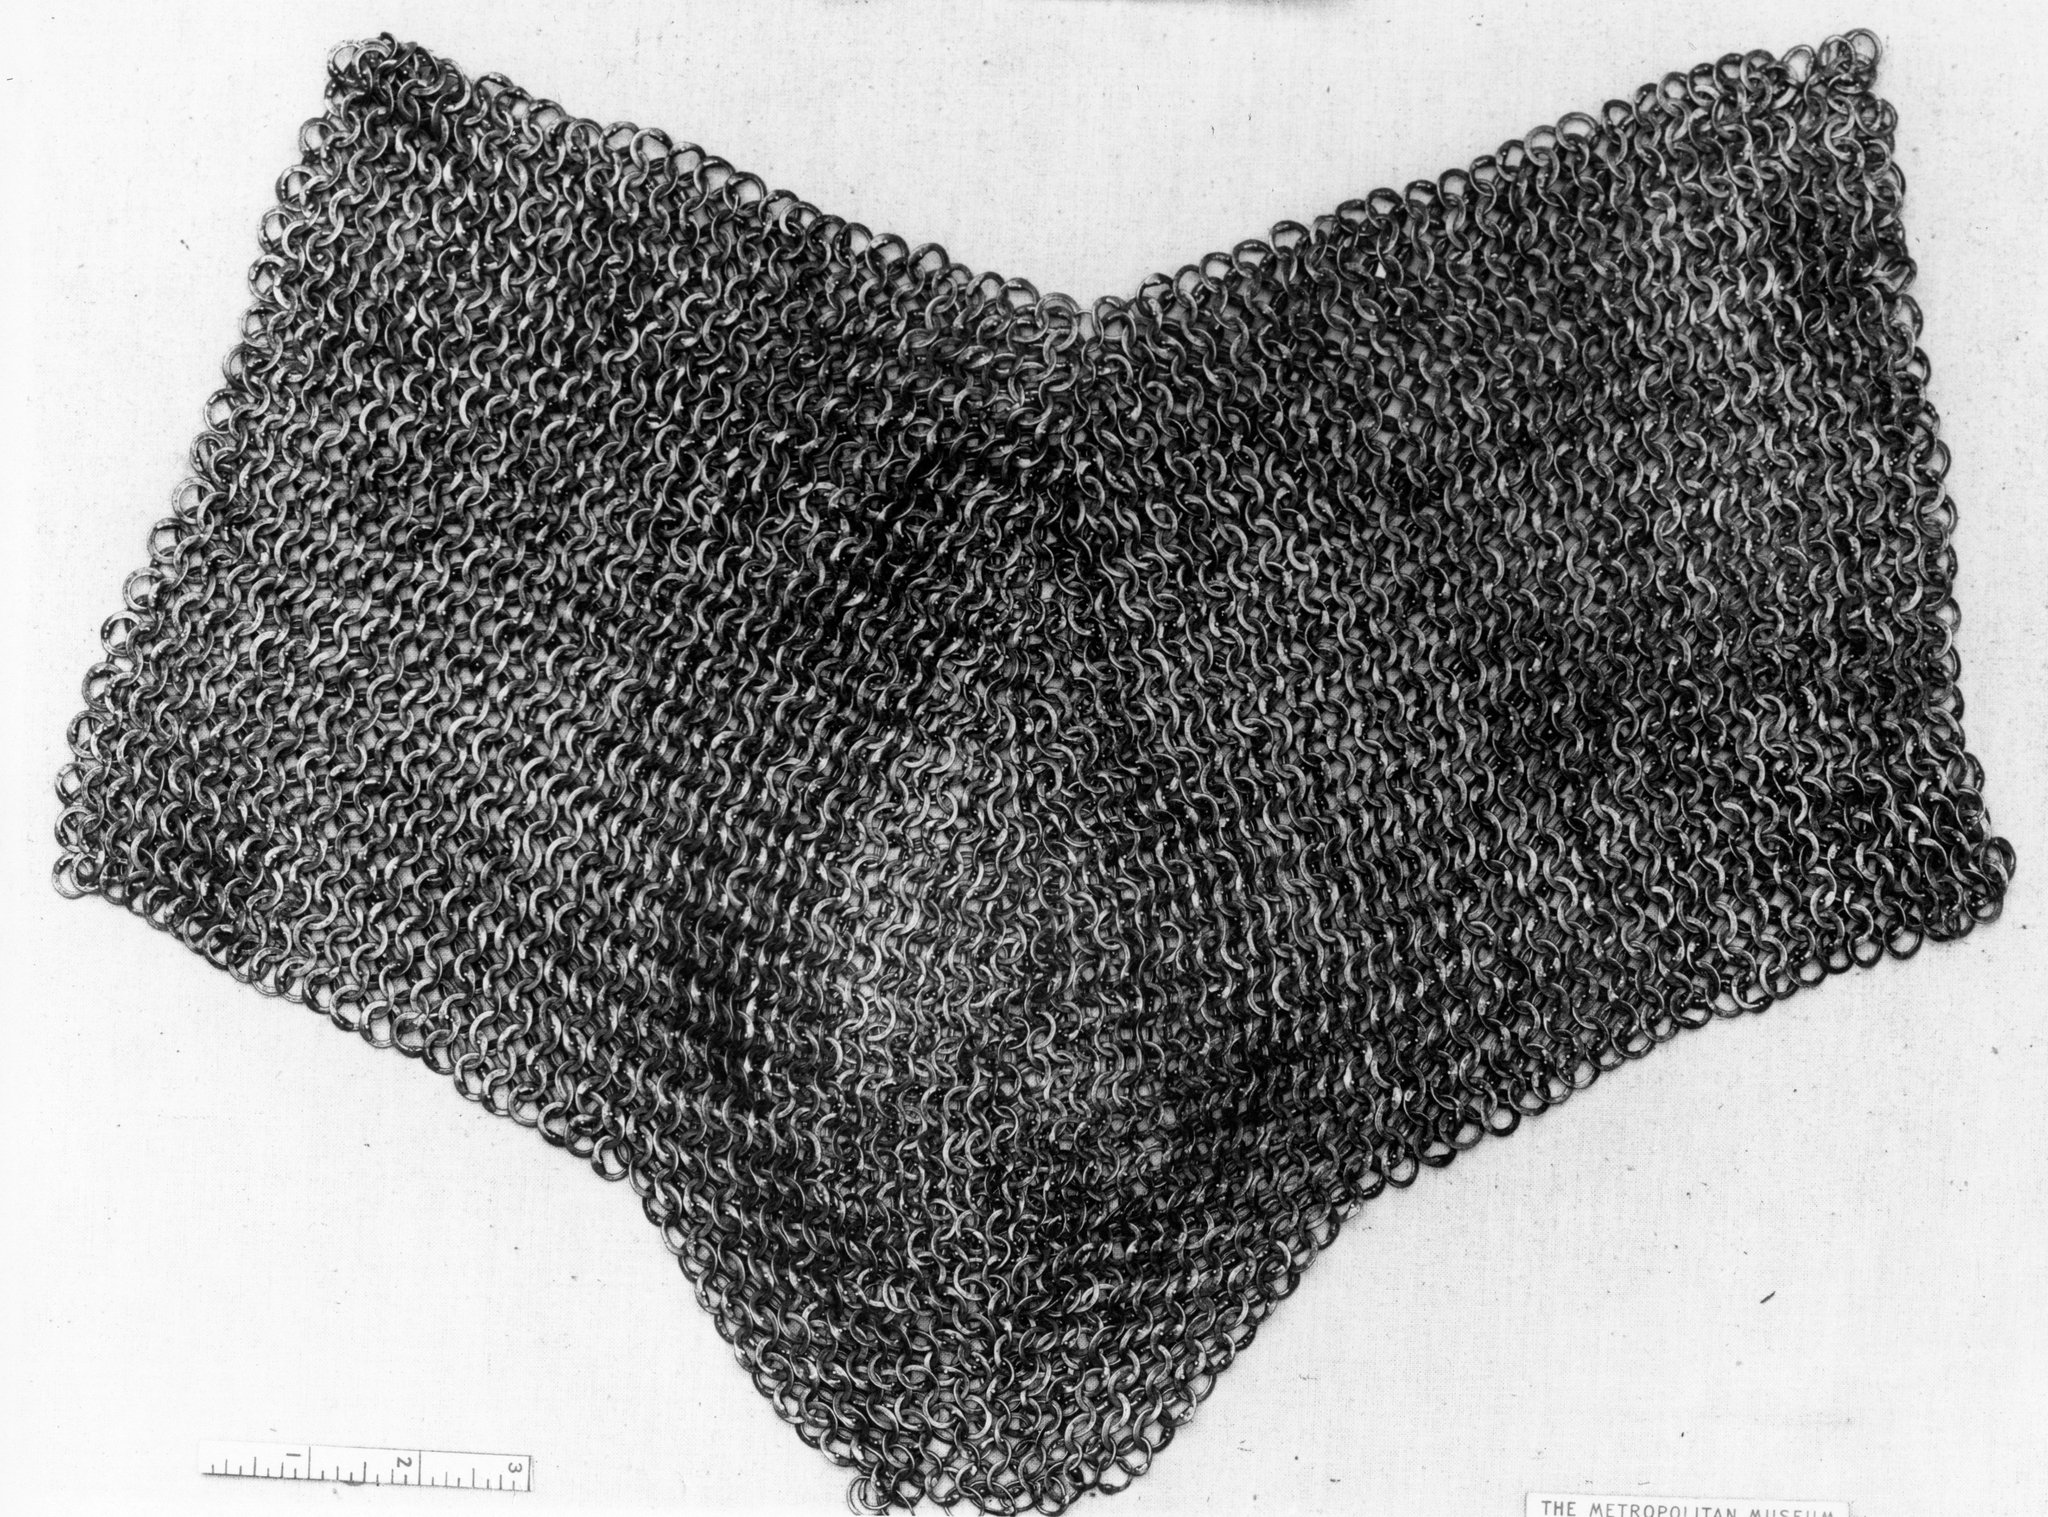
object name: brayette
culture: german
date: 1501-1600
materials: steel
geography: germany